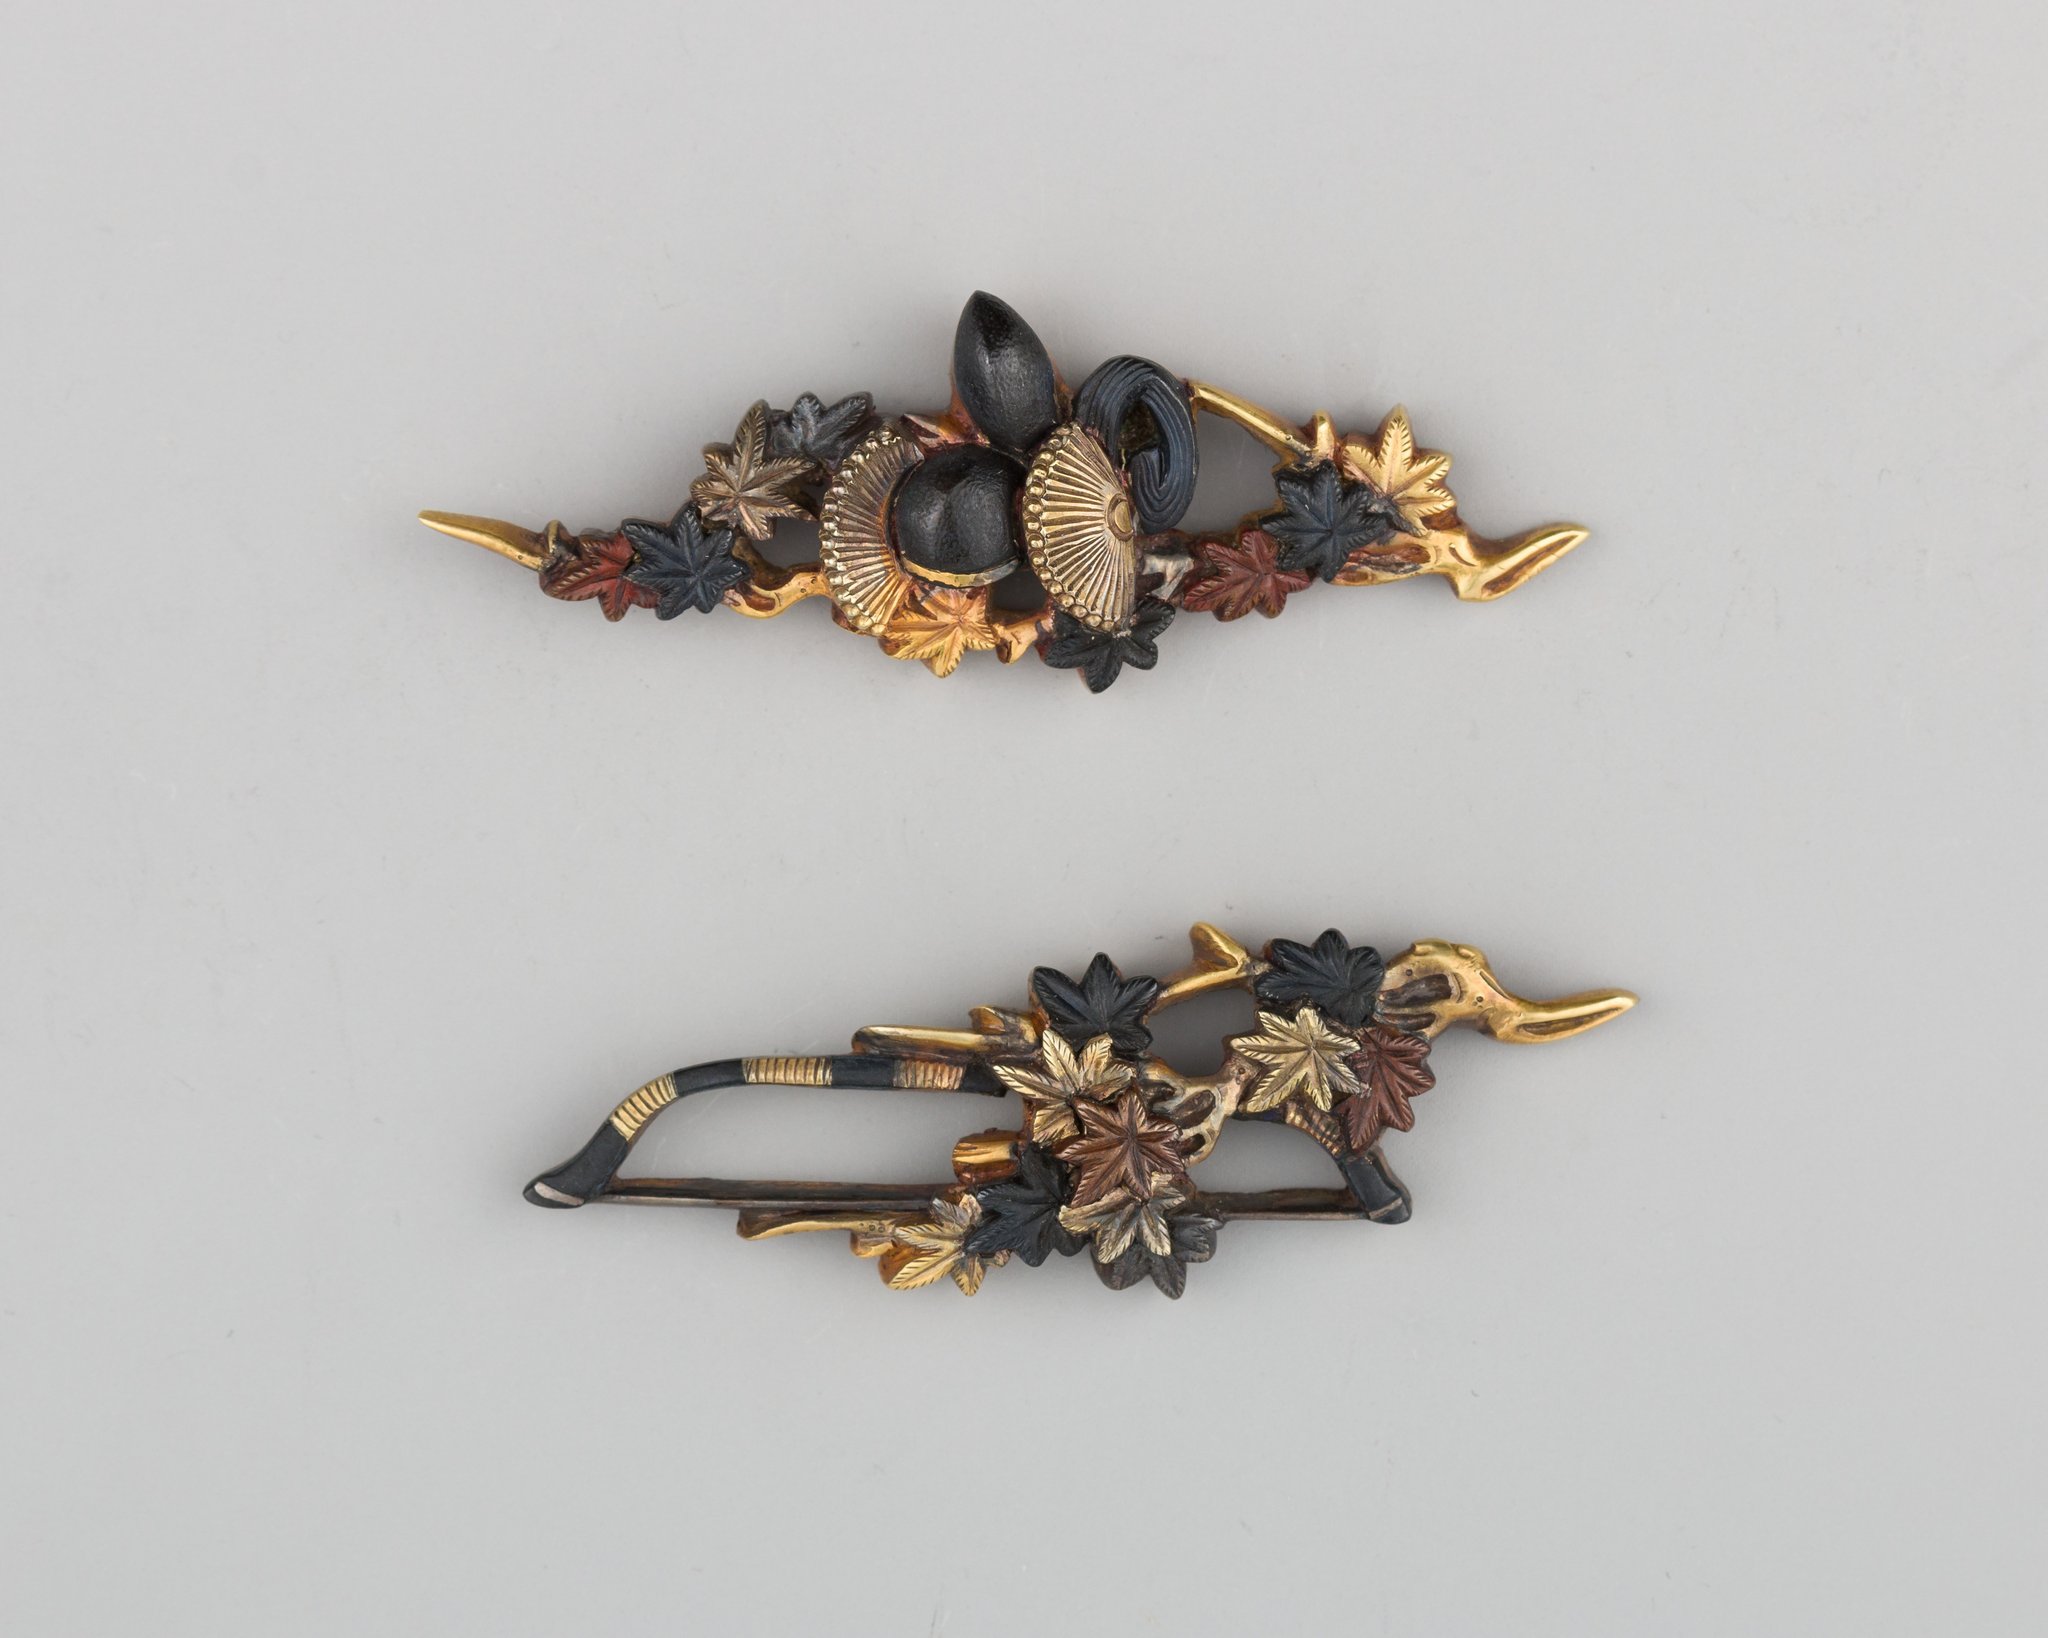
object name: pair of sword grip ornament menuki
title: Pair of Sword-Grip Ornaments (Menuki)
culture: japanese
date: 1701-1800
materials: copper, gold alloy, gold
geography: japan